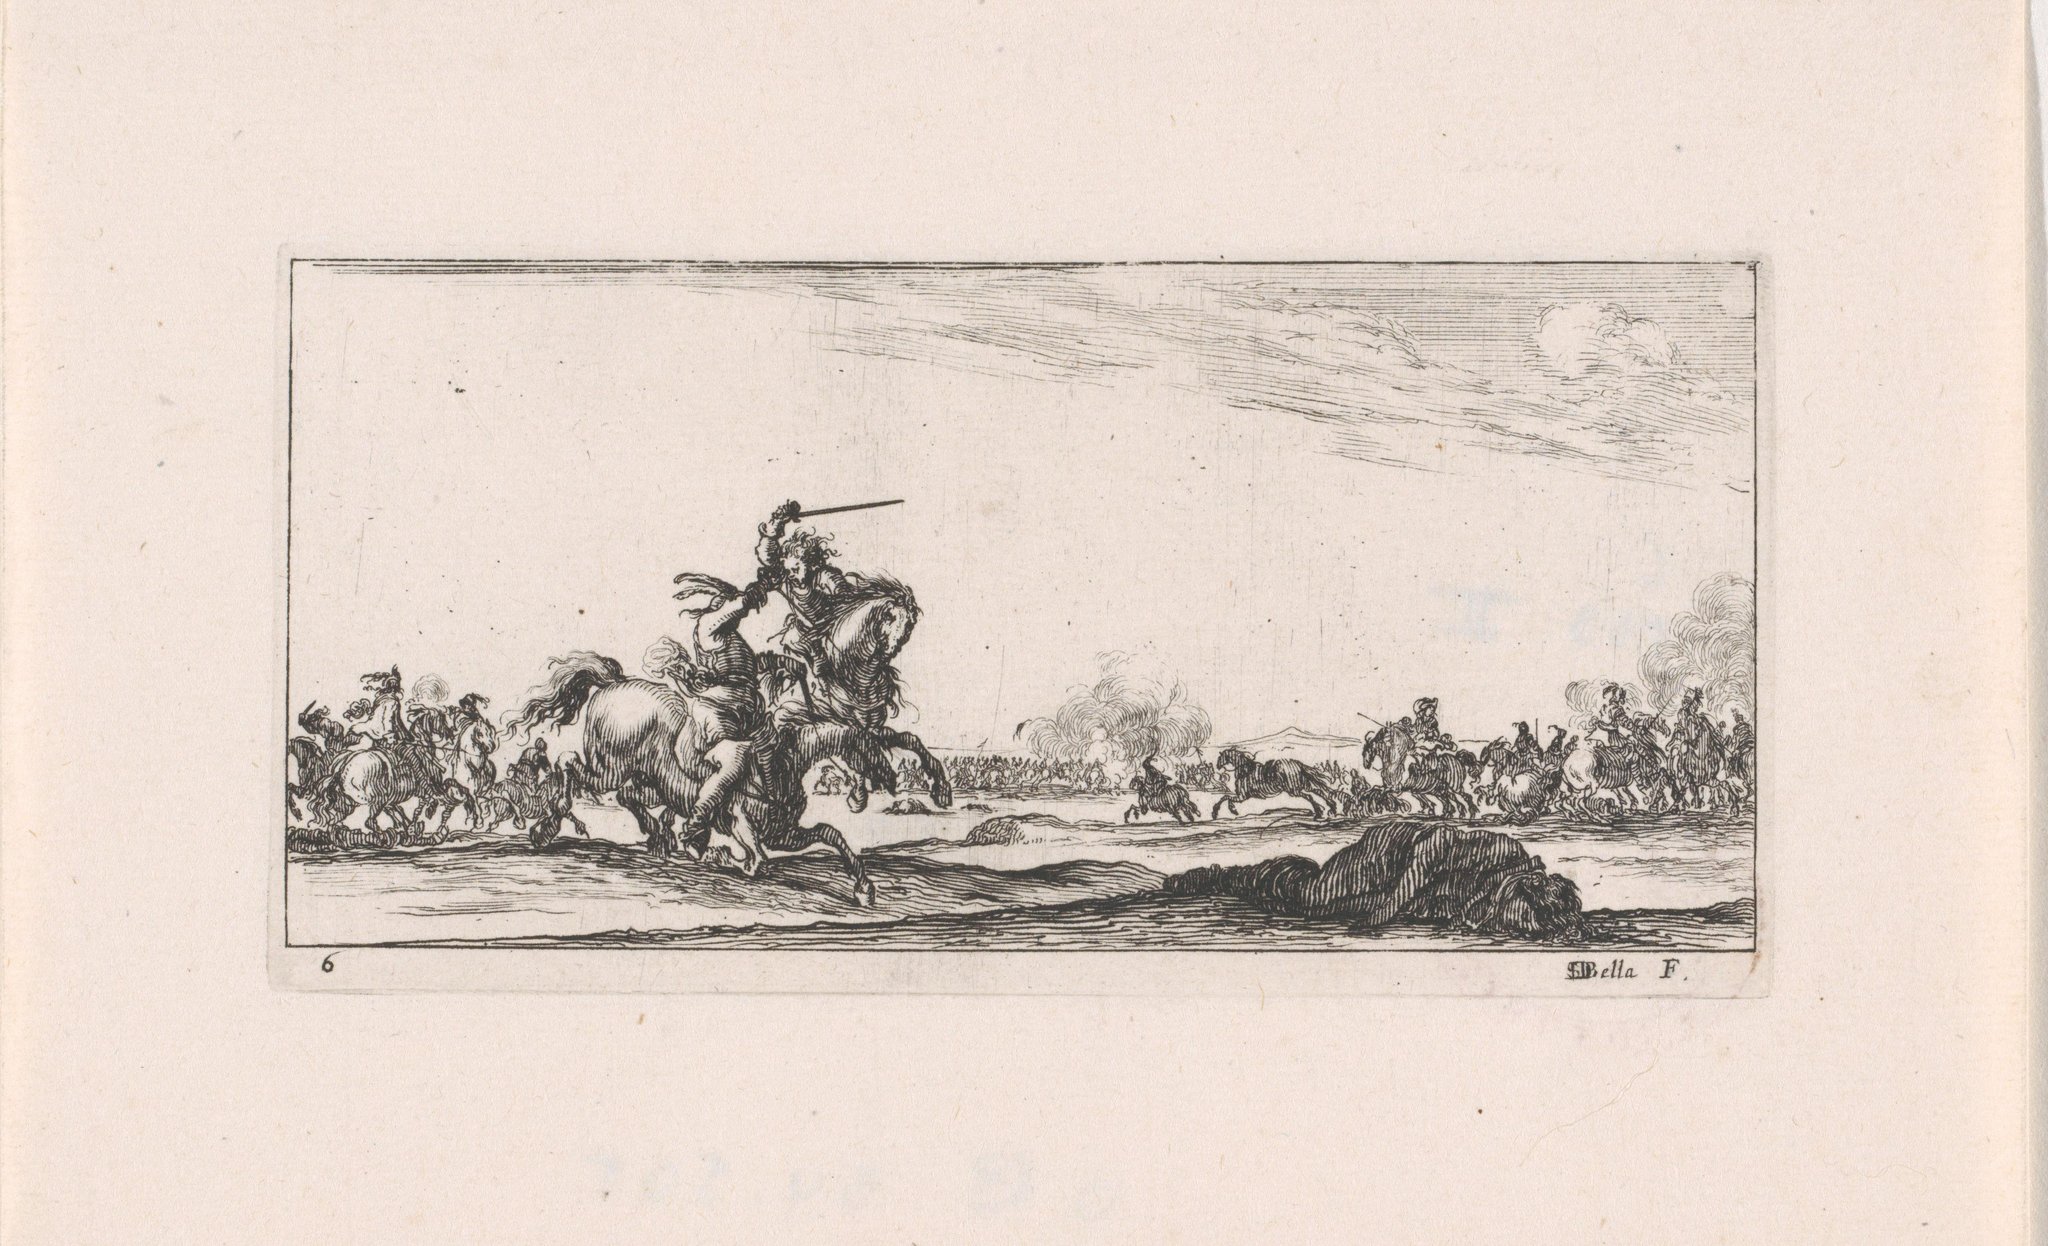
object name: print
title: Soldaten te paard in gevecht op een slagveld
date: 1620-1664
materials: paper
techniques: etching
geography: paris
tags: riding a horse, ass, or mule; rider, horseman, battle, warfare; military affairs (+ cavalry, horsemen), the soldier; the soldier's life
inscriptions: collector's mark: Lugt 240